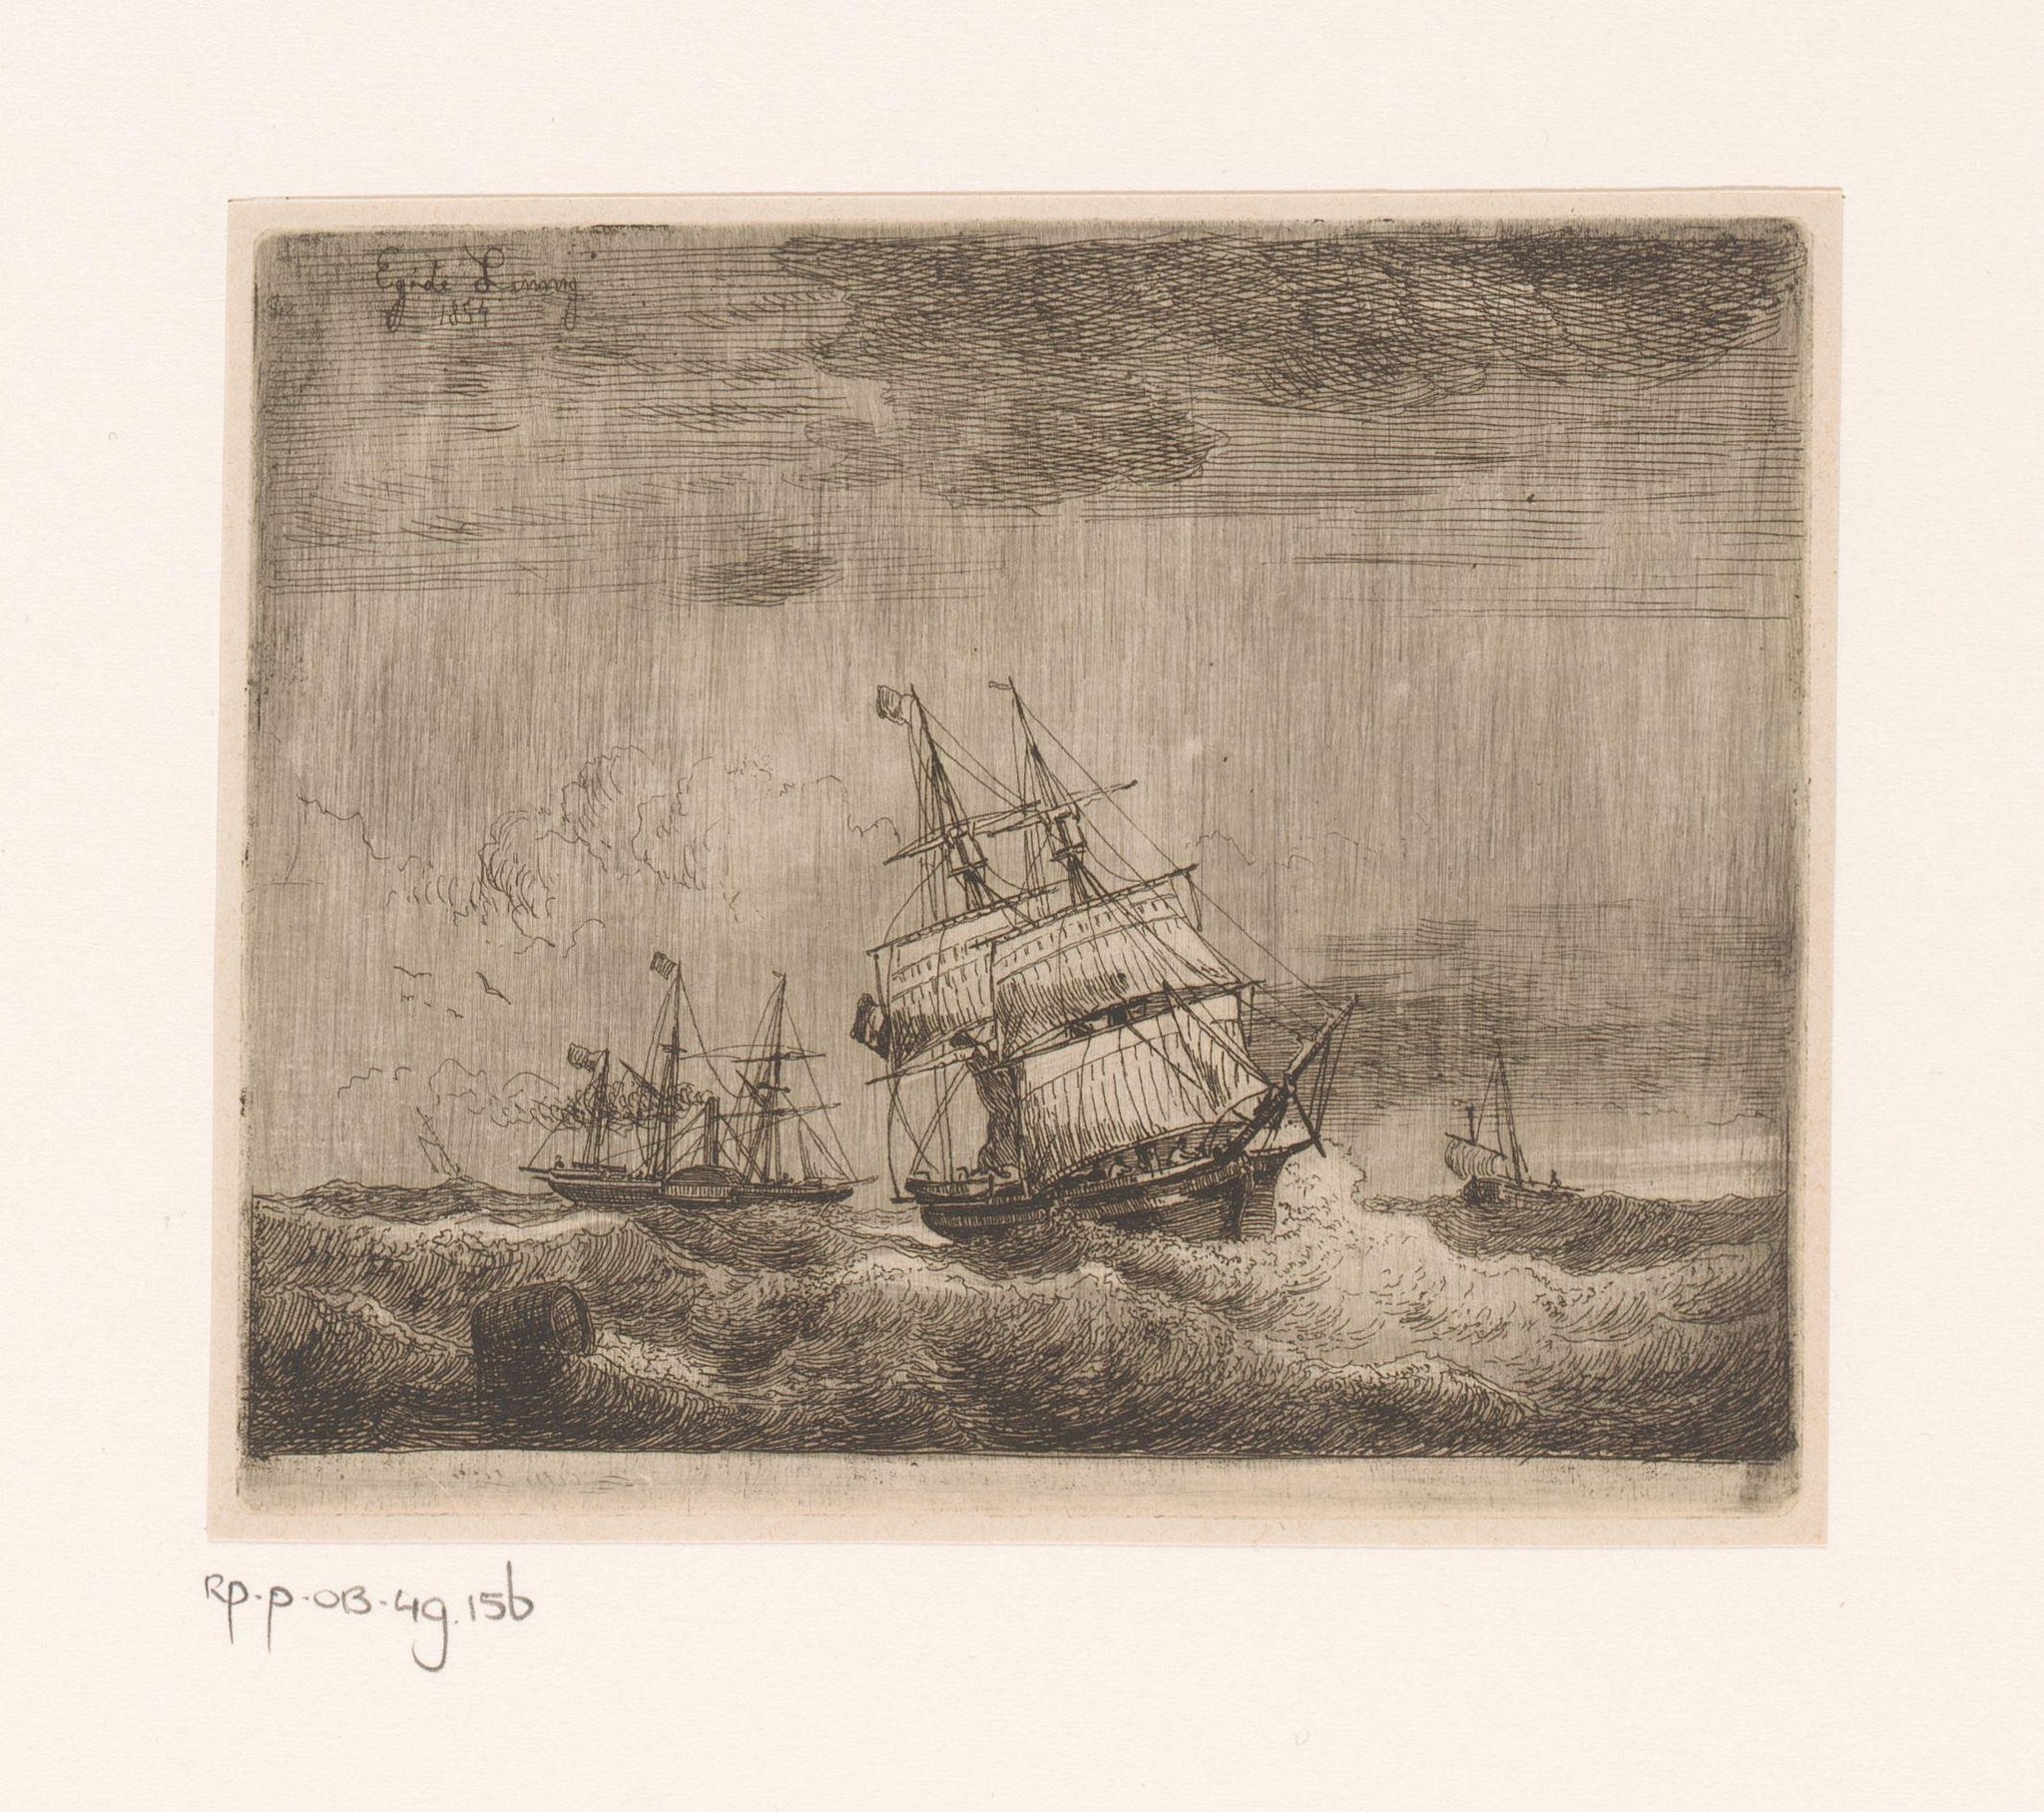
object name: print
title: Zeilschepen en een raderstoomschip op zee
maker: egidius linnig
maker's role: draughtsman, print maker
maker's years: 1821-1860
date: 1854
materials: paper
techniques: etching, intaglio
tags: sailing-ship, sailing-boat, paddle-wheel boat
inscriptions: collector's mark: Lugt 2228